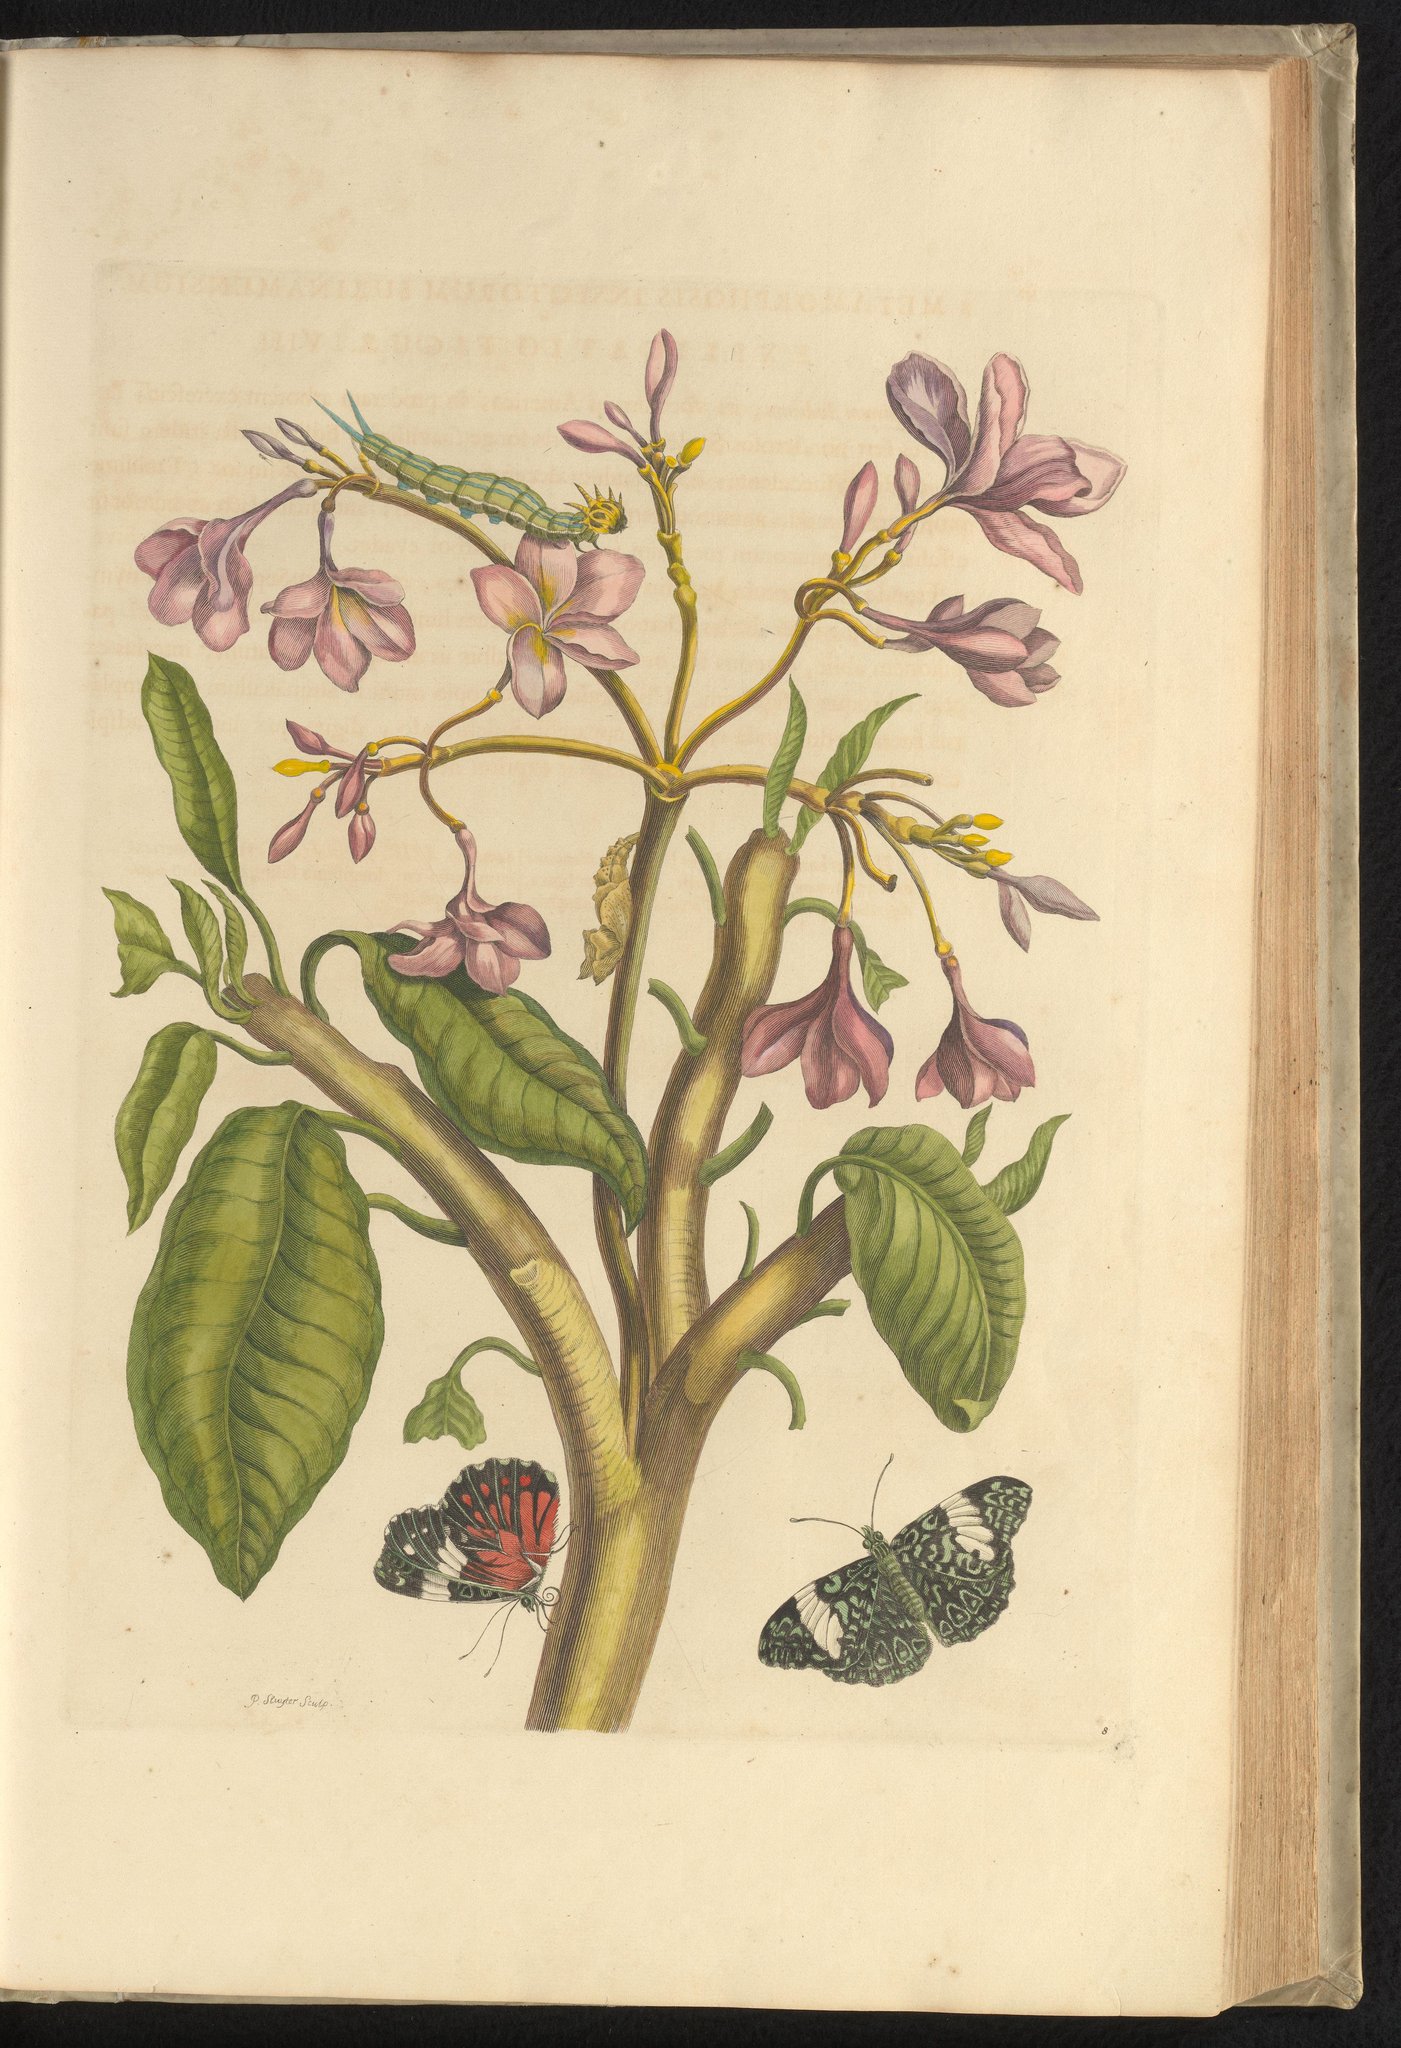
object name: page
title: Tempelboom (Plumeria rubra) met twee vlinders, rups en pop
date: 1705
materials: paper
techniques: etching, hand coloring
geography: suriname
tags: trees, insects: pupa, insects: butterfly, insects: caterpillar, suriname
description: Rechtsonder genummerd: 8. Prent maakt deel uit van een boek.